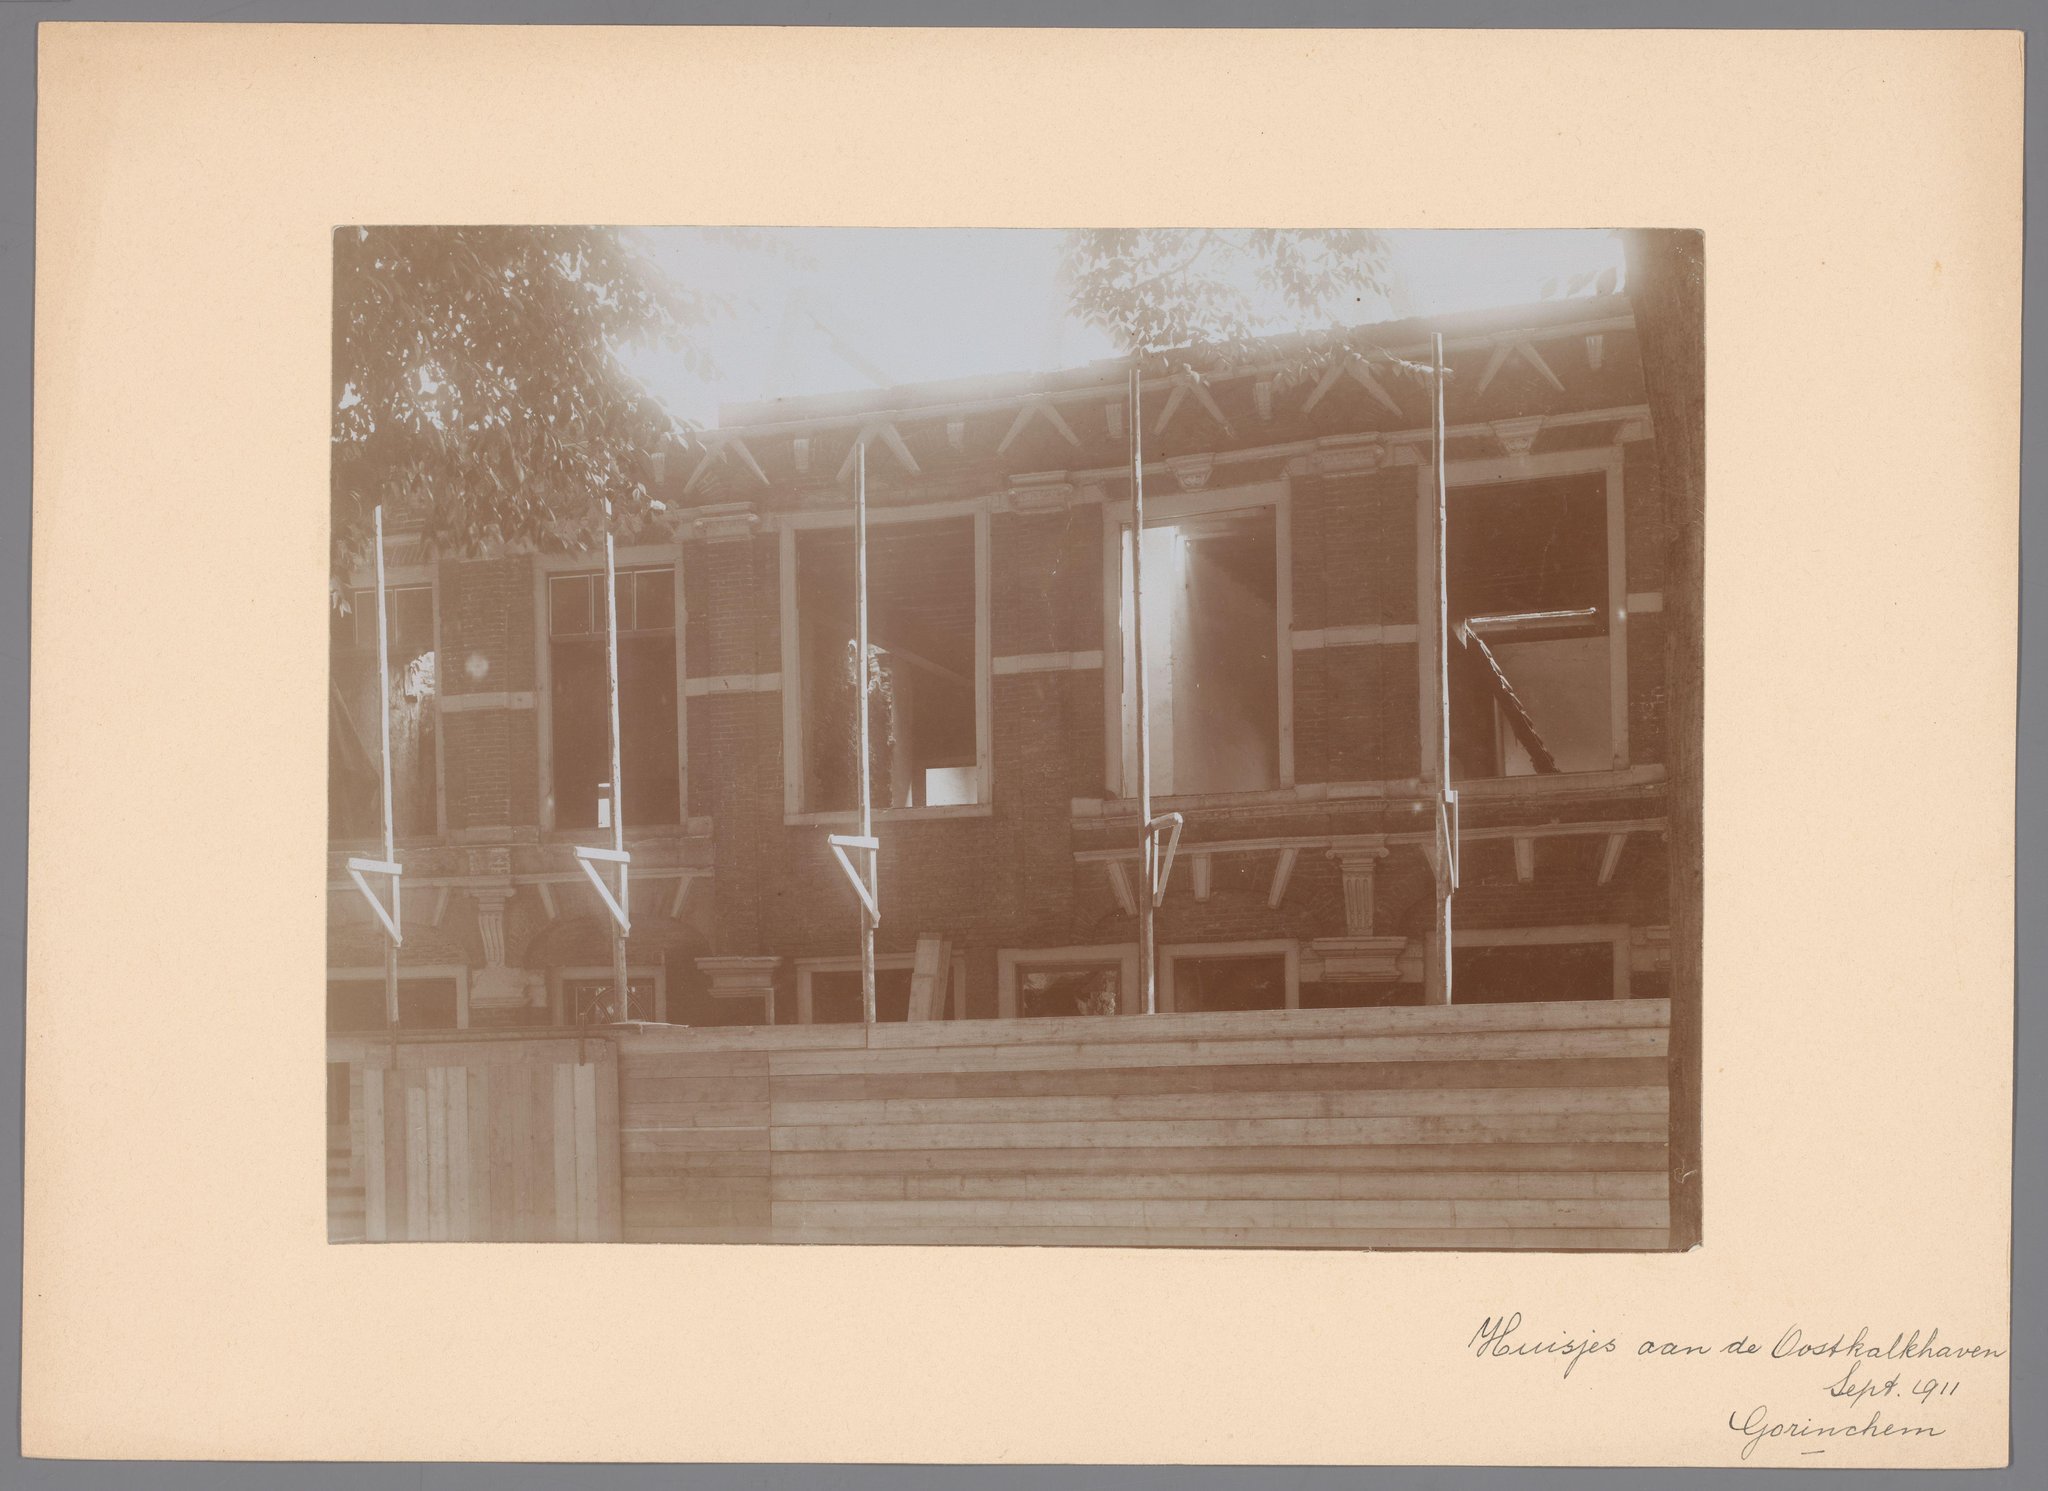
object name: photograph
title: Woningen aan de Kalkhaven te Gorinchem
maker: anoniem (monumentenzorg)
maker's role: fotograaf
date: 1911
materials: cardboard, photographic support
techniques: collodion silver print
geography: kalkhaven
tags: urban housing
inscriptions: annotation: ‘Huisjes aan de oostkalkhaven/ Sept. 1911/ Gorinchem’